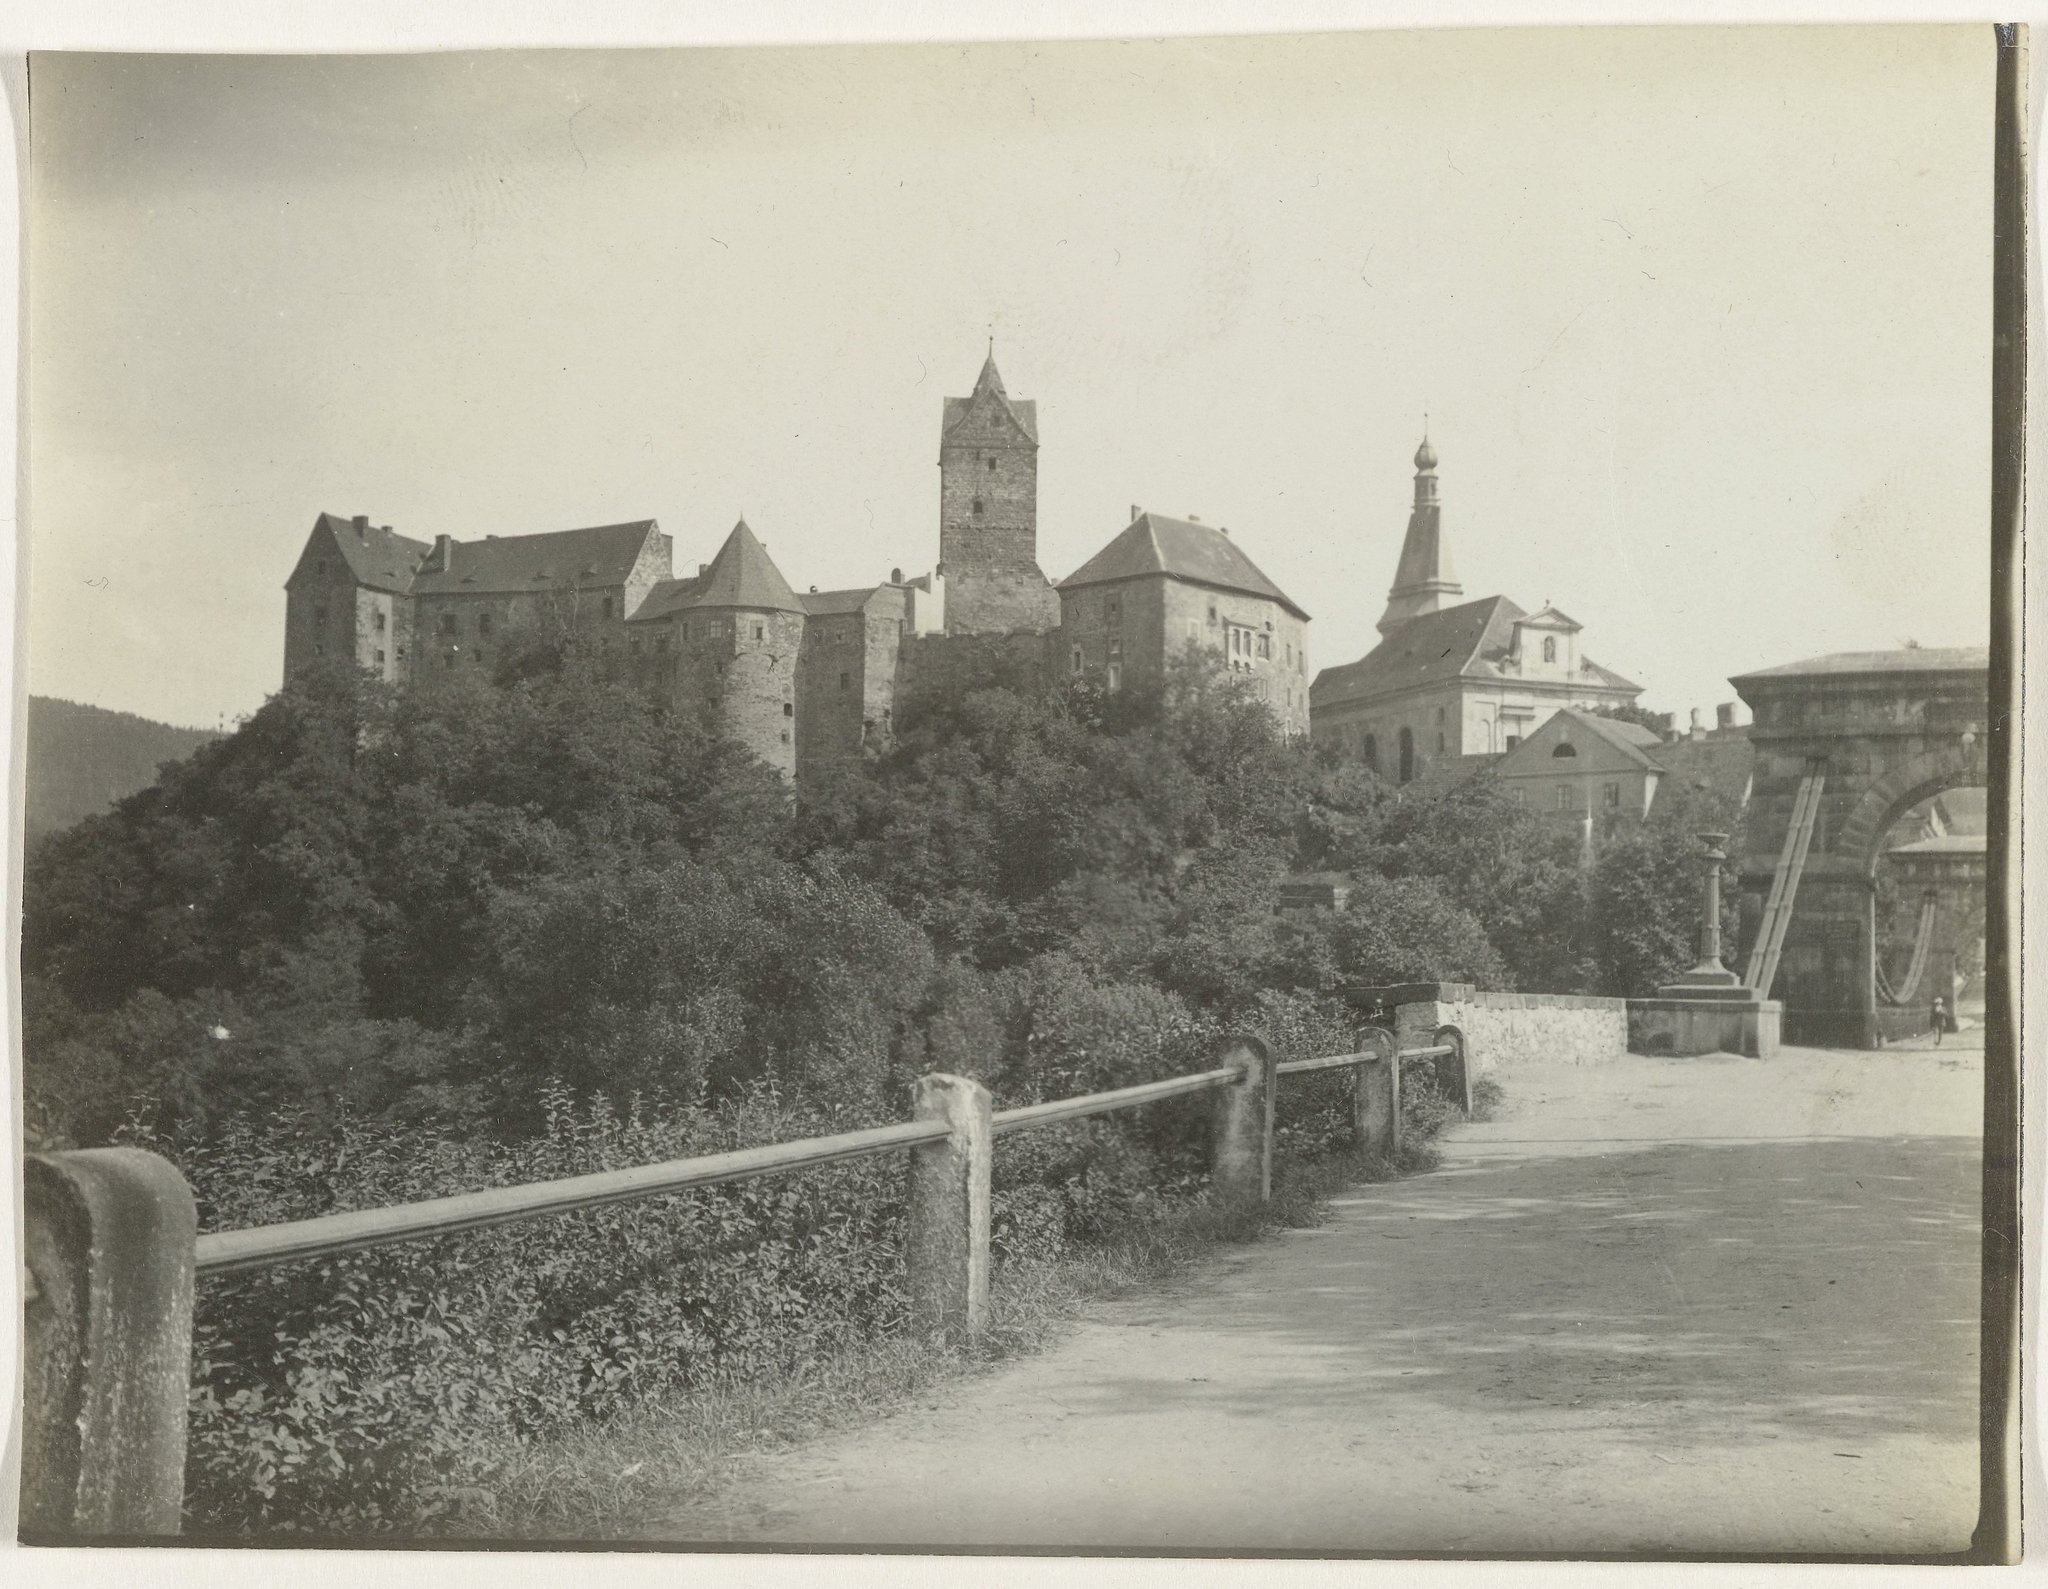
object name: photograph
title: Gezicht op een burcht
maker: Anonymous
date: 1900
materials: paper, photographic support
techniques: gelatin silver print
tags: fortress, castle